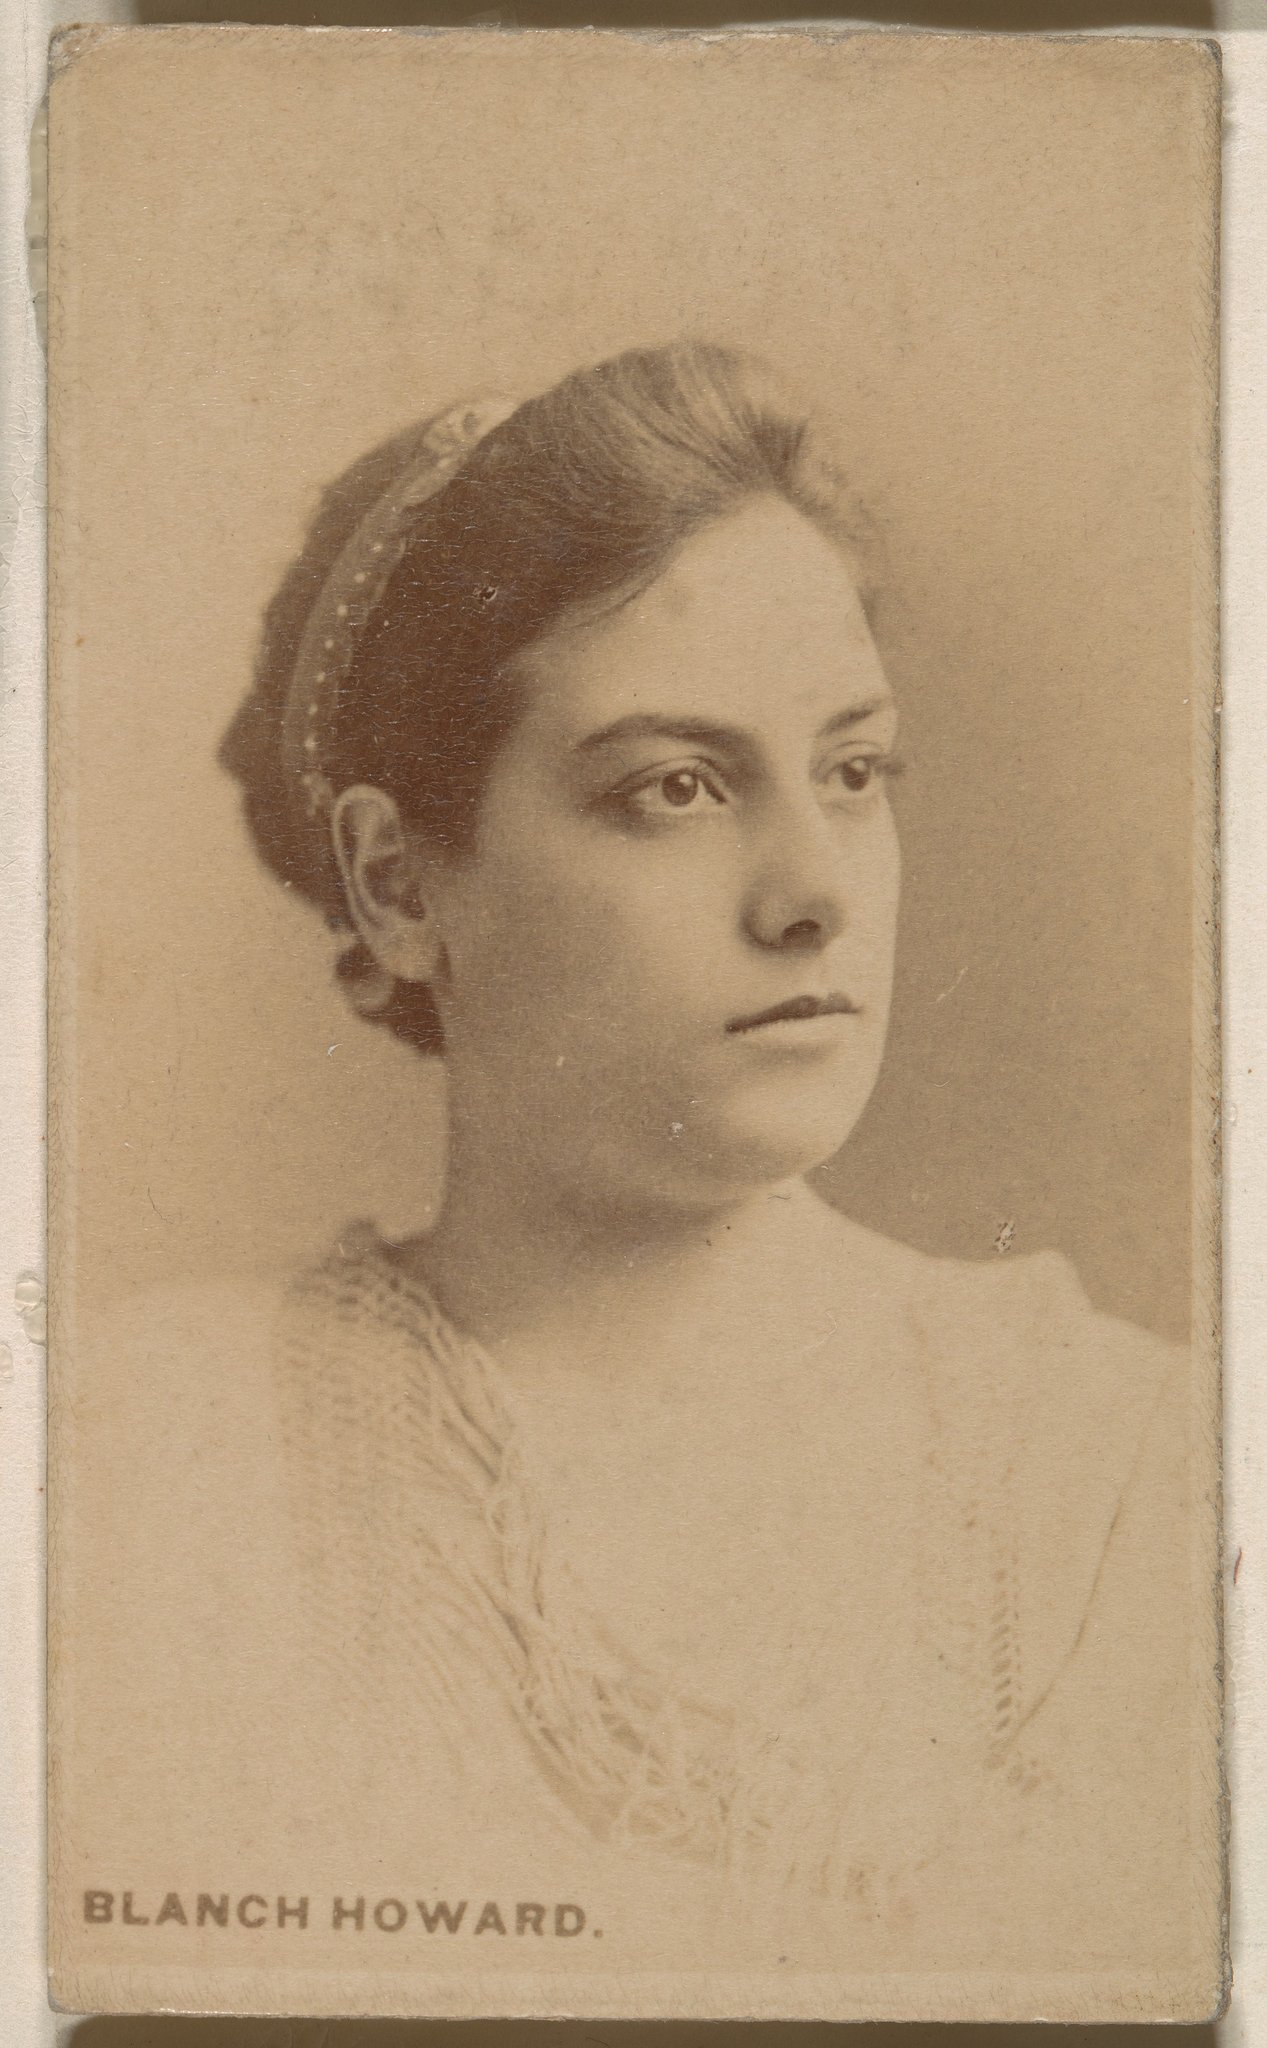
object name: photograph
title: Blanch Howard, from the Actresses series (N246), Type 1, issued by Kinney Brothers to promote Sporting Extra Cigarettes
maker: kinney brothers tobacco company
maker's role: publisher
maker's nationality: american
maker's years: 1869-2011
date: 1890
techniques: albumen silver print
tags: portraits,women,actresses